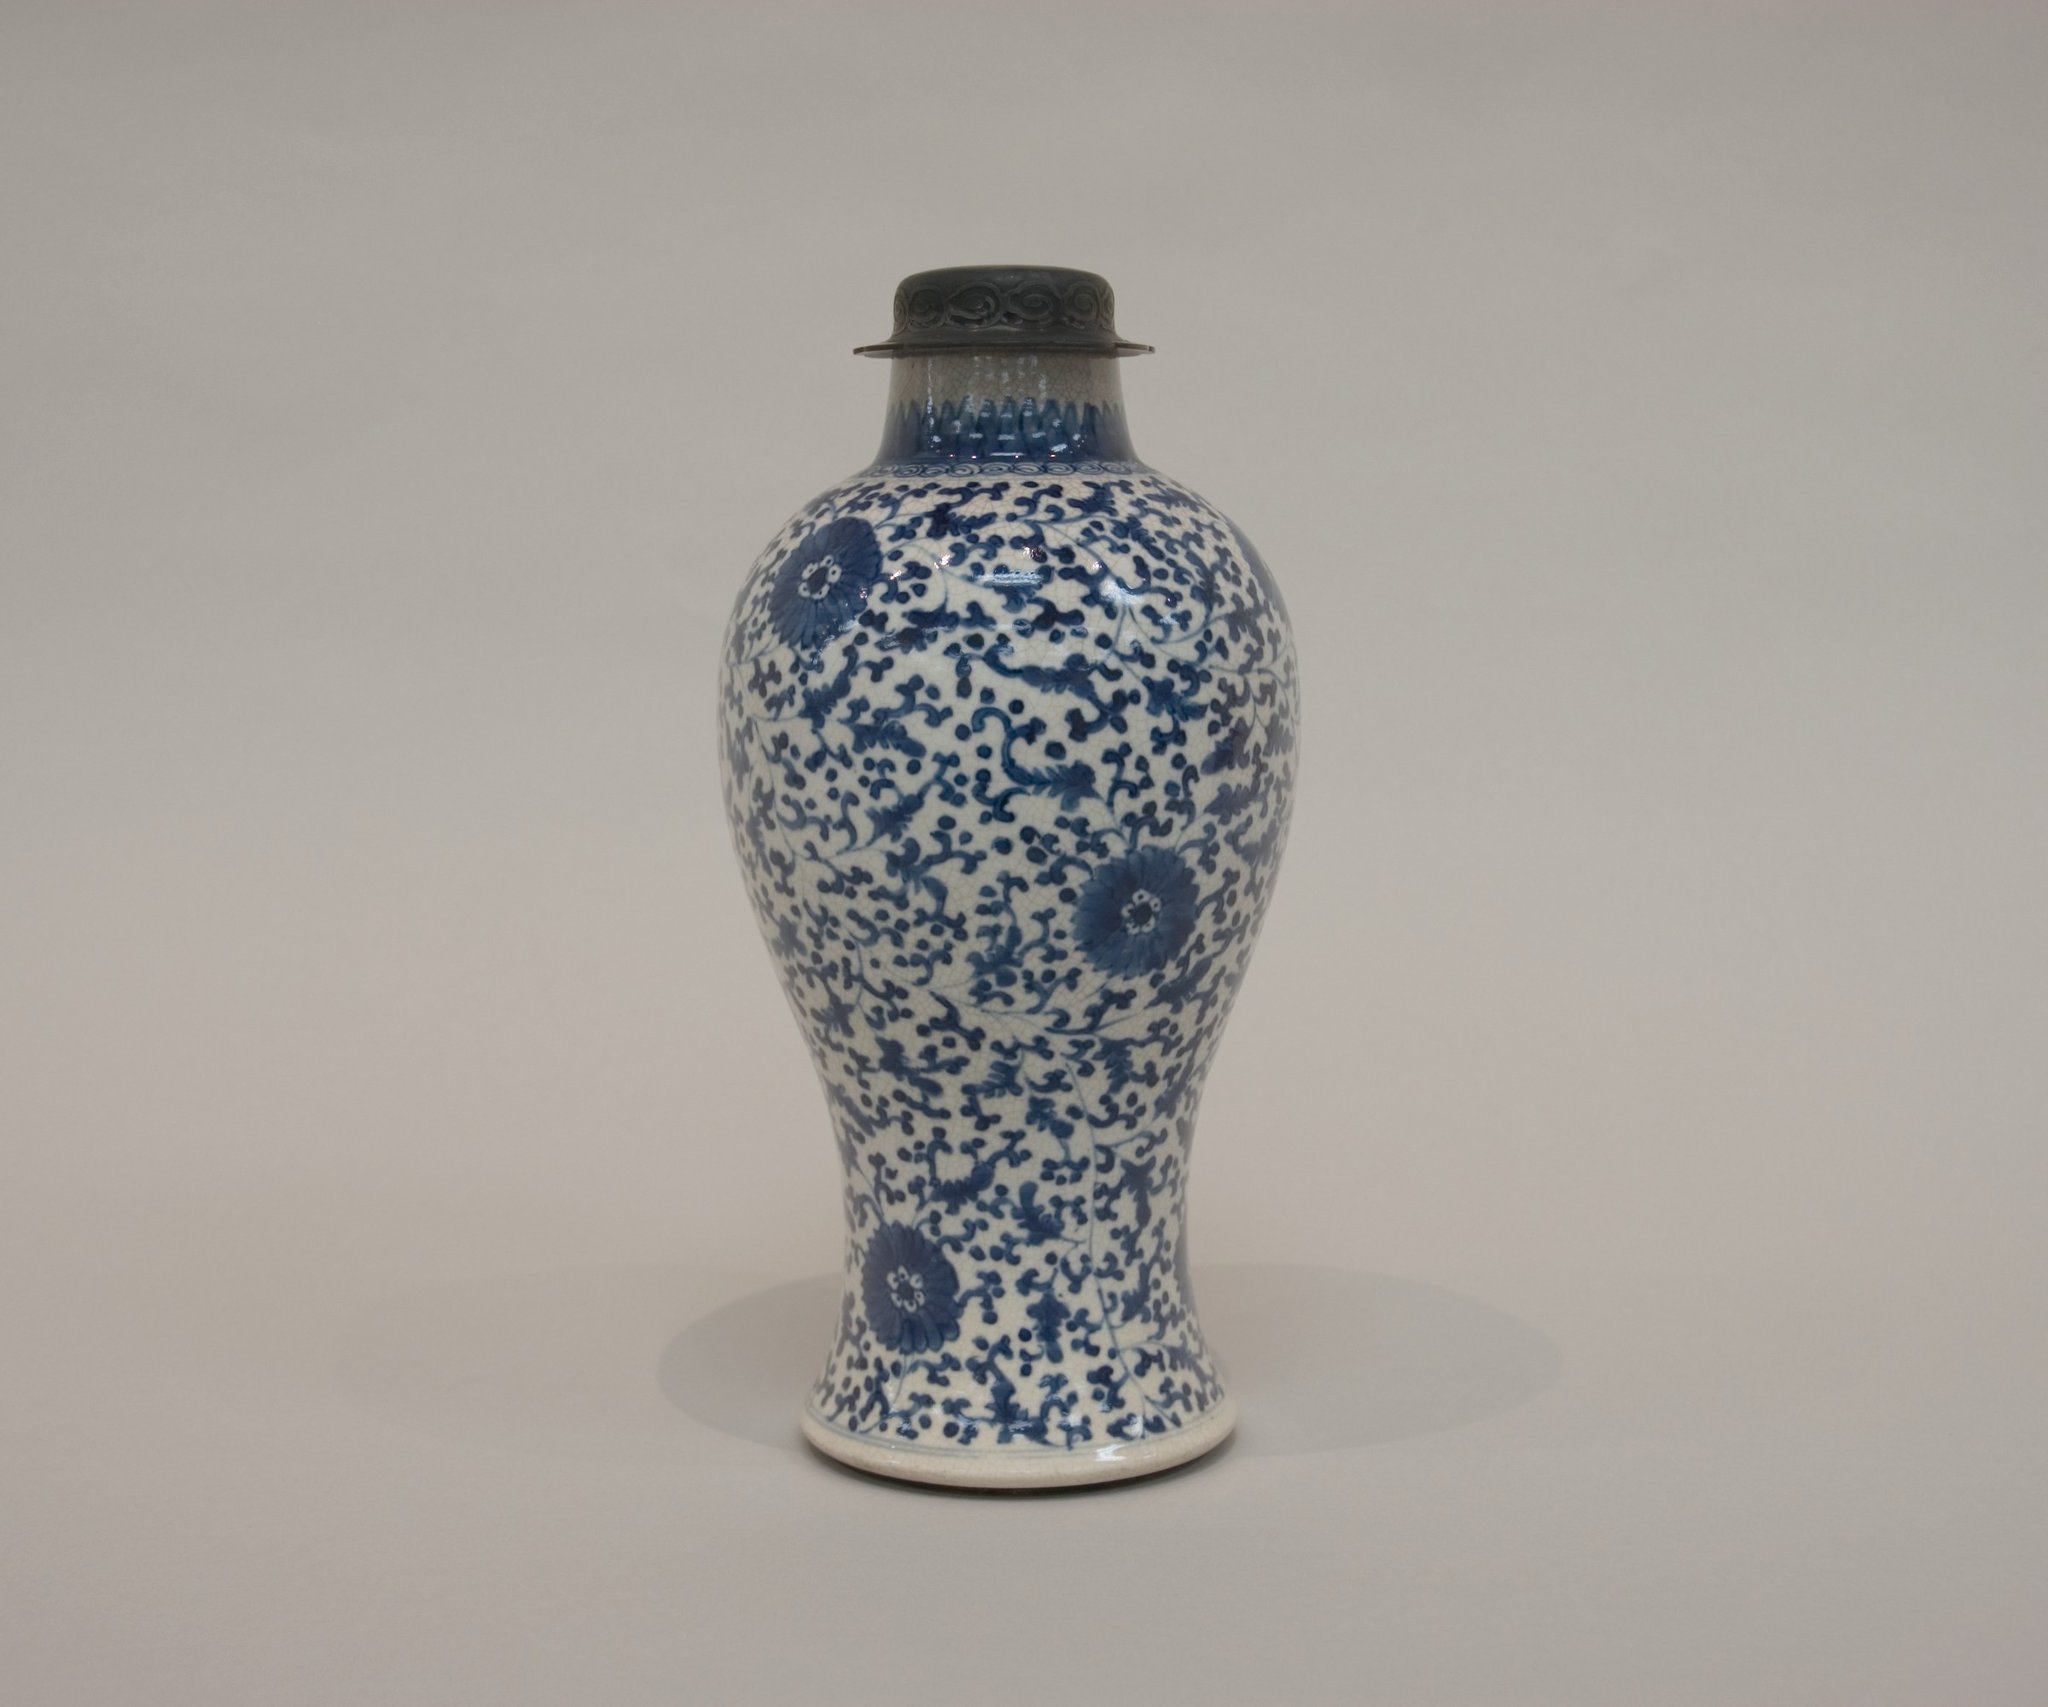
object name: vase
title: Vase with floral scrolls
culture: chinese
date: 1667-1733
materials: cobalt, porcelain, silver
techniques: painting, underglaze